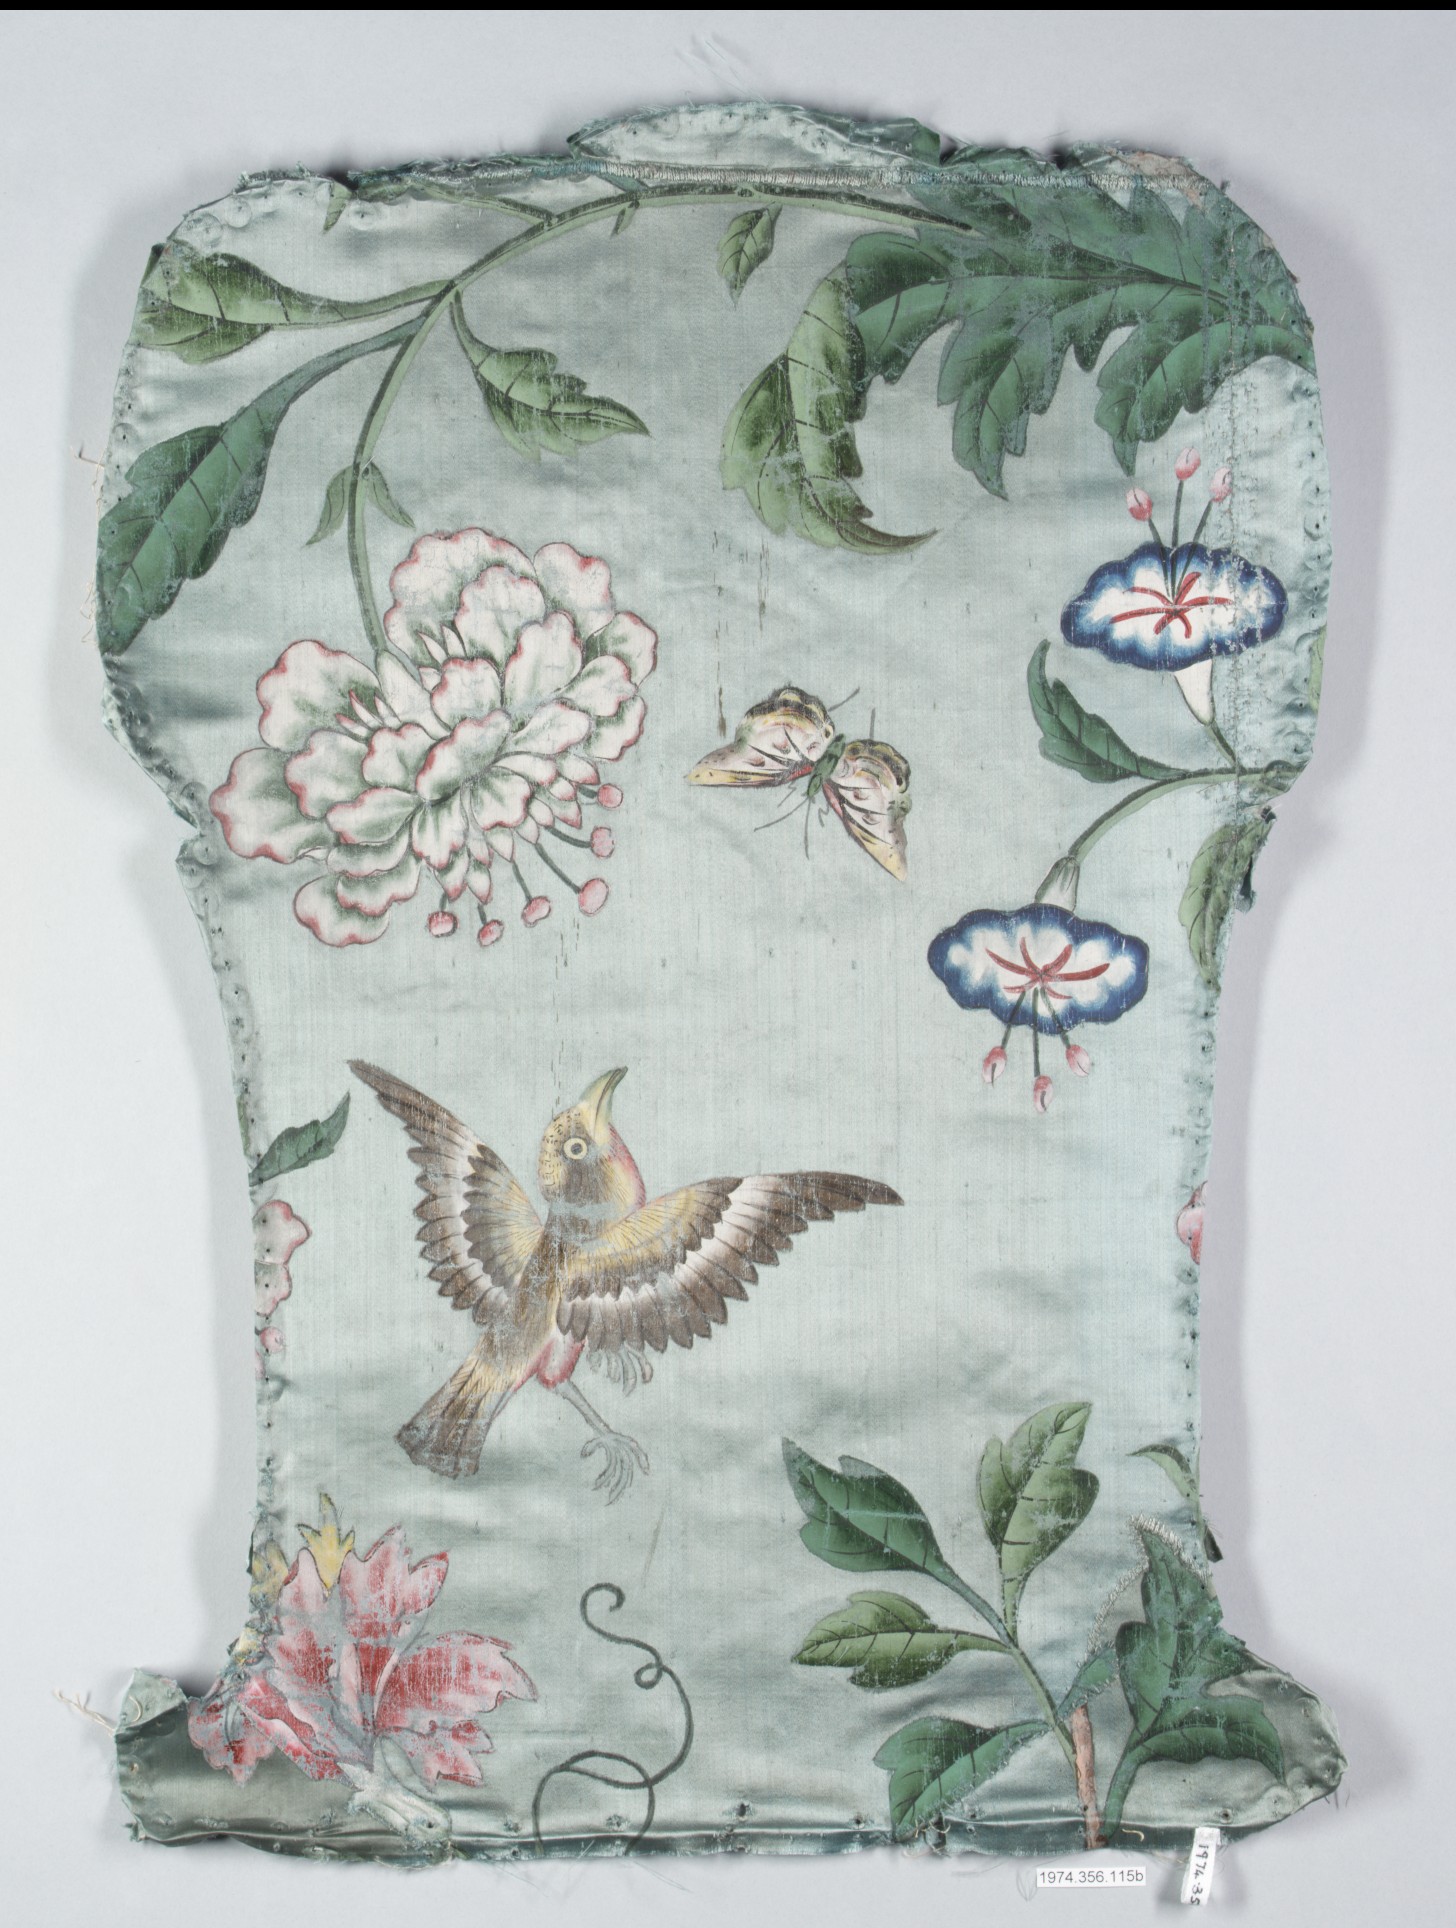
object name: upholstery panel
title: Upholstery panels for a side chair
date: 1763-1764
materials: silk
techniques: painting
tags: birds,butterflies,flowers